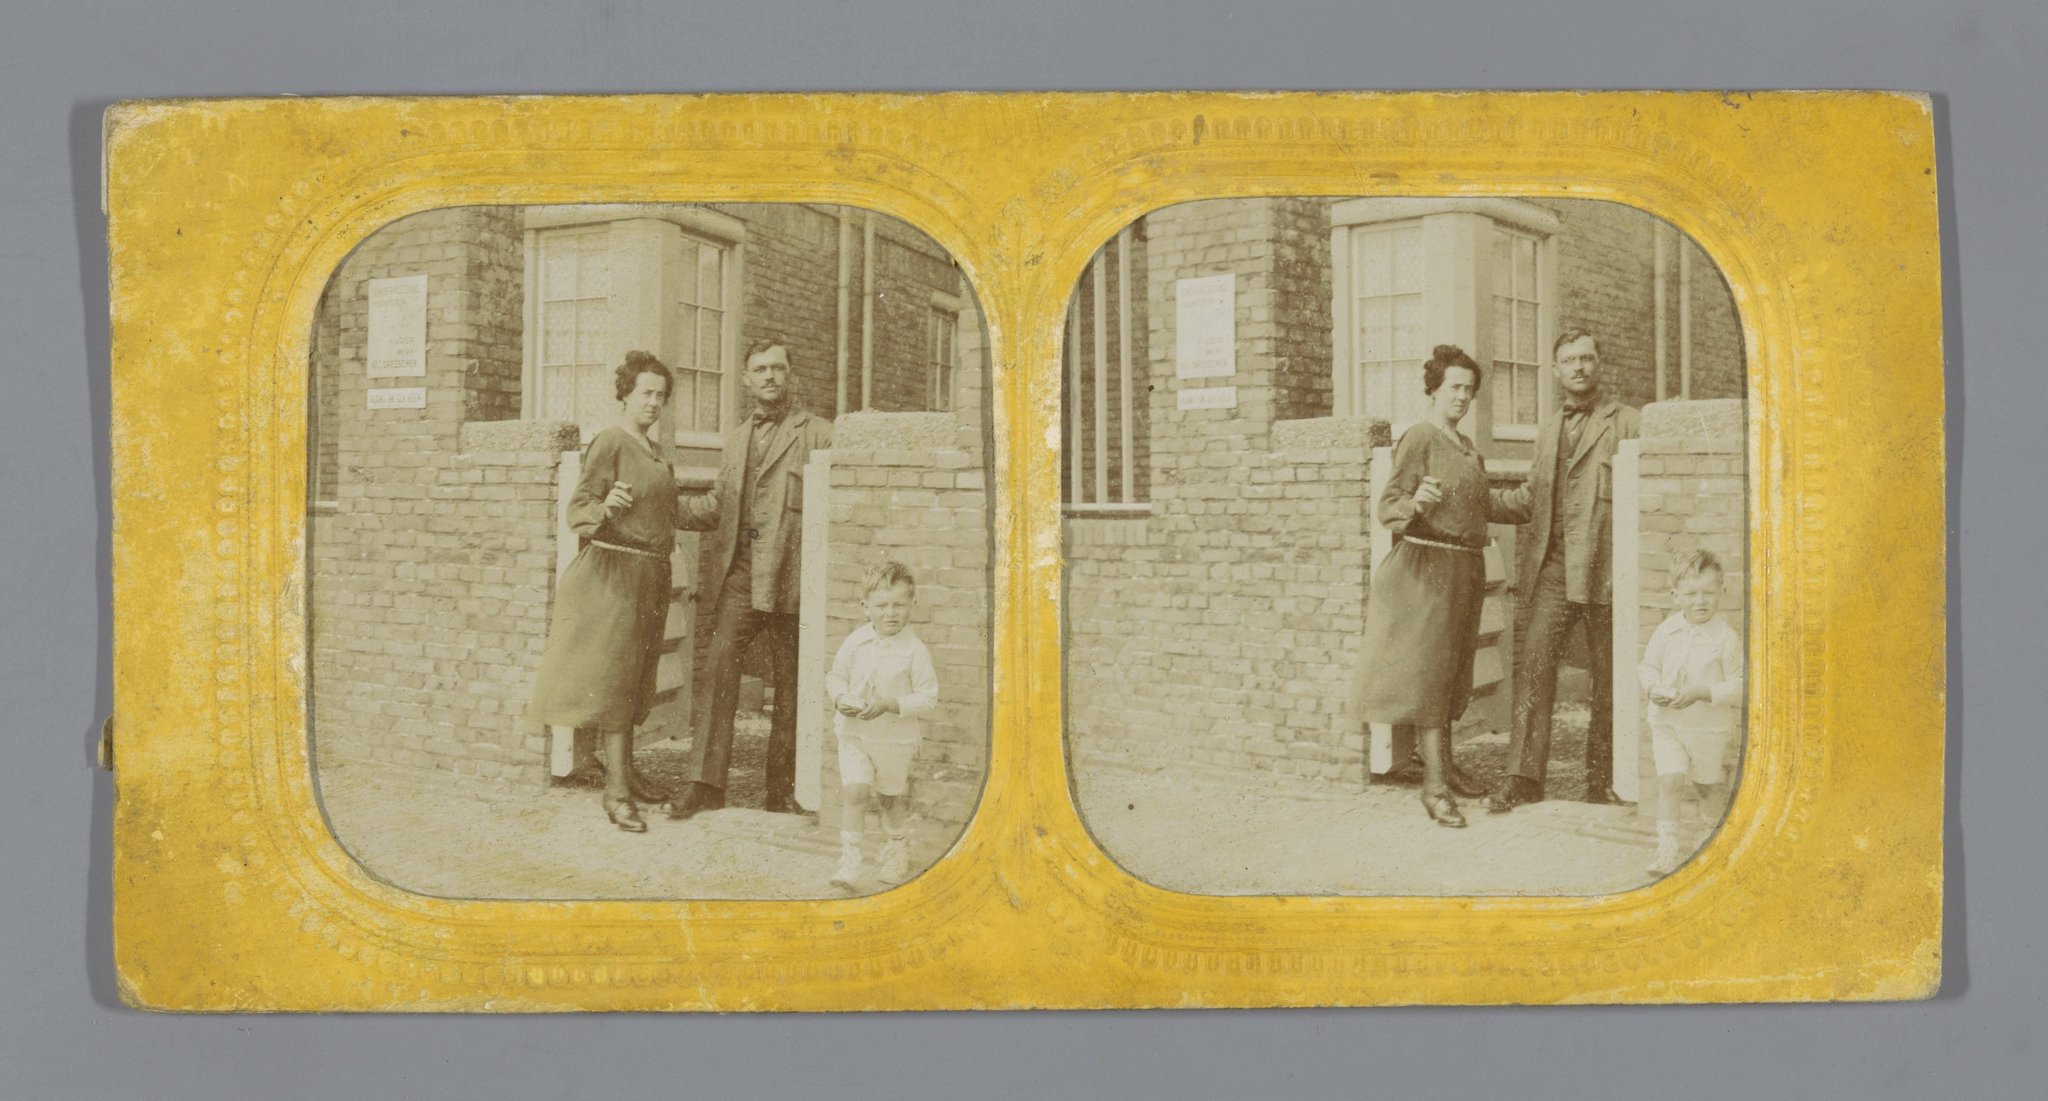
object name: tissue stereograph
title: Echtpaar met kind voor huis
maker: Anonymous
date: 1910-1940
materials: cardboard, paper, photographic support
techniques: albumen print, hand coloring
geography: netherlands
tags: family group, especially parents with their child(ren)